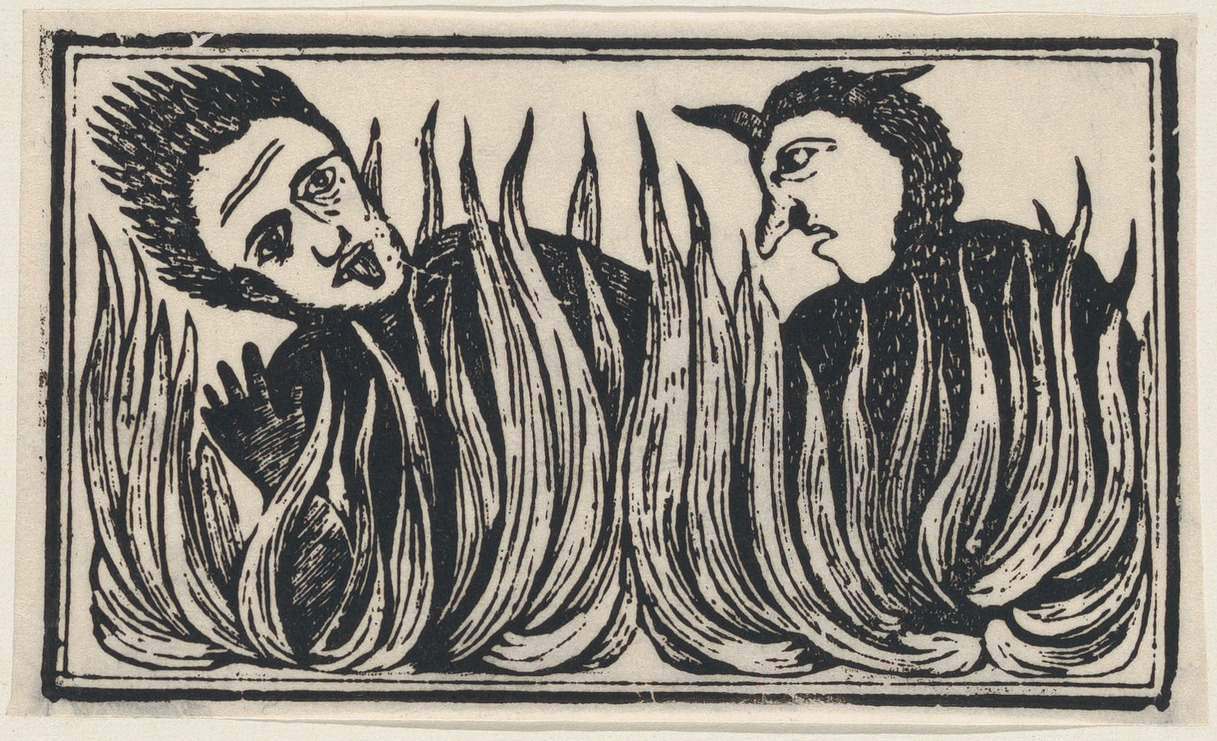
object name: print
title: Demons engulfed in flames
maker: anonymous, mexican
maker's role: artist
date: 1801-1900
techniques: woodcut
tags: demons